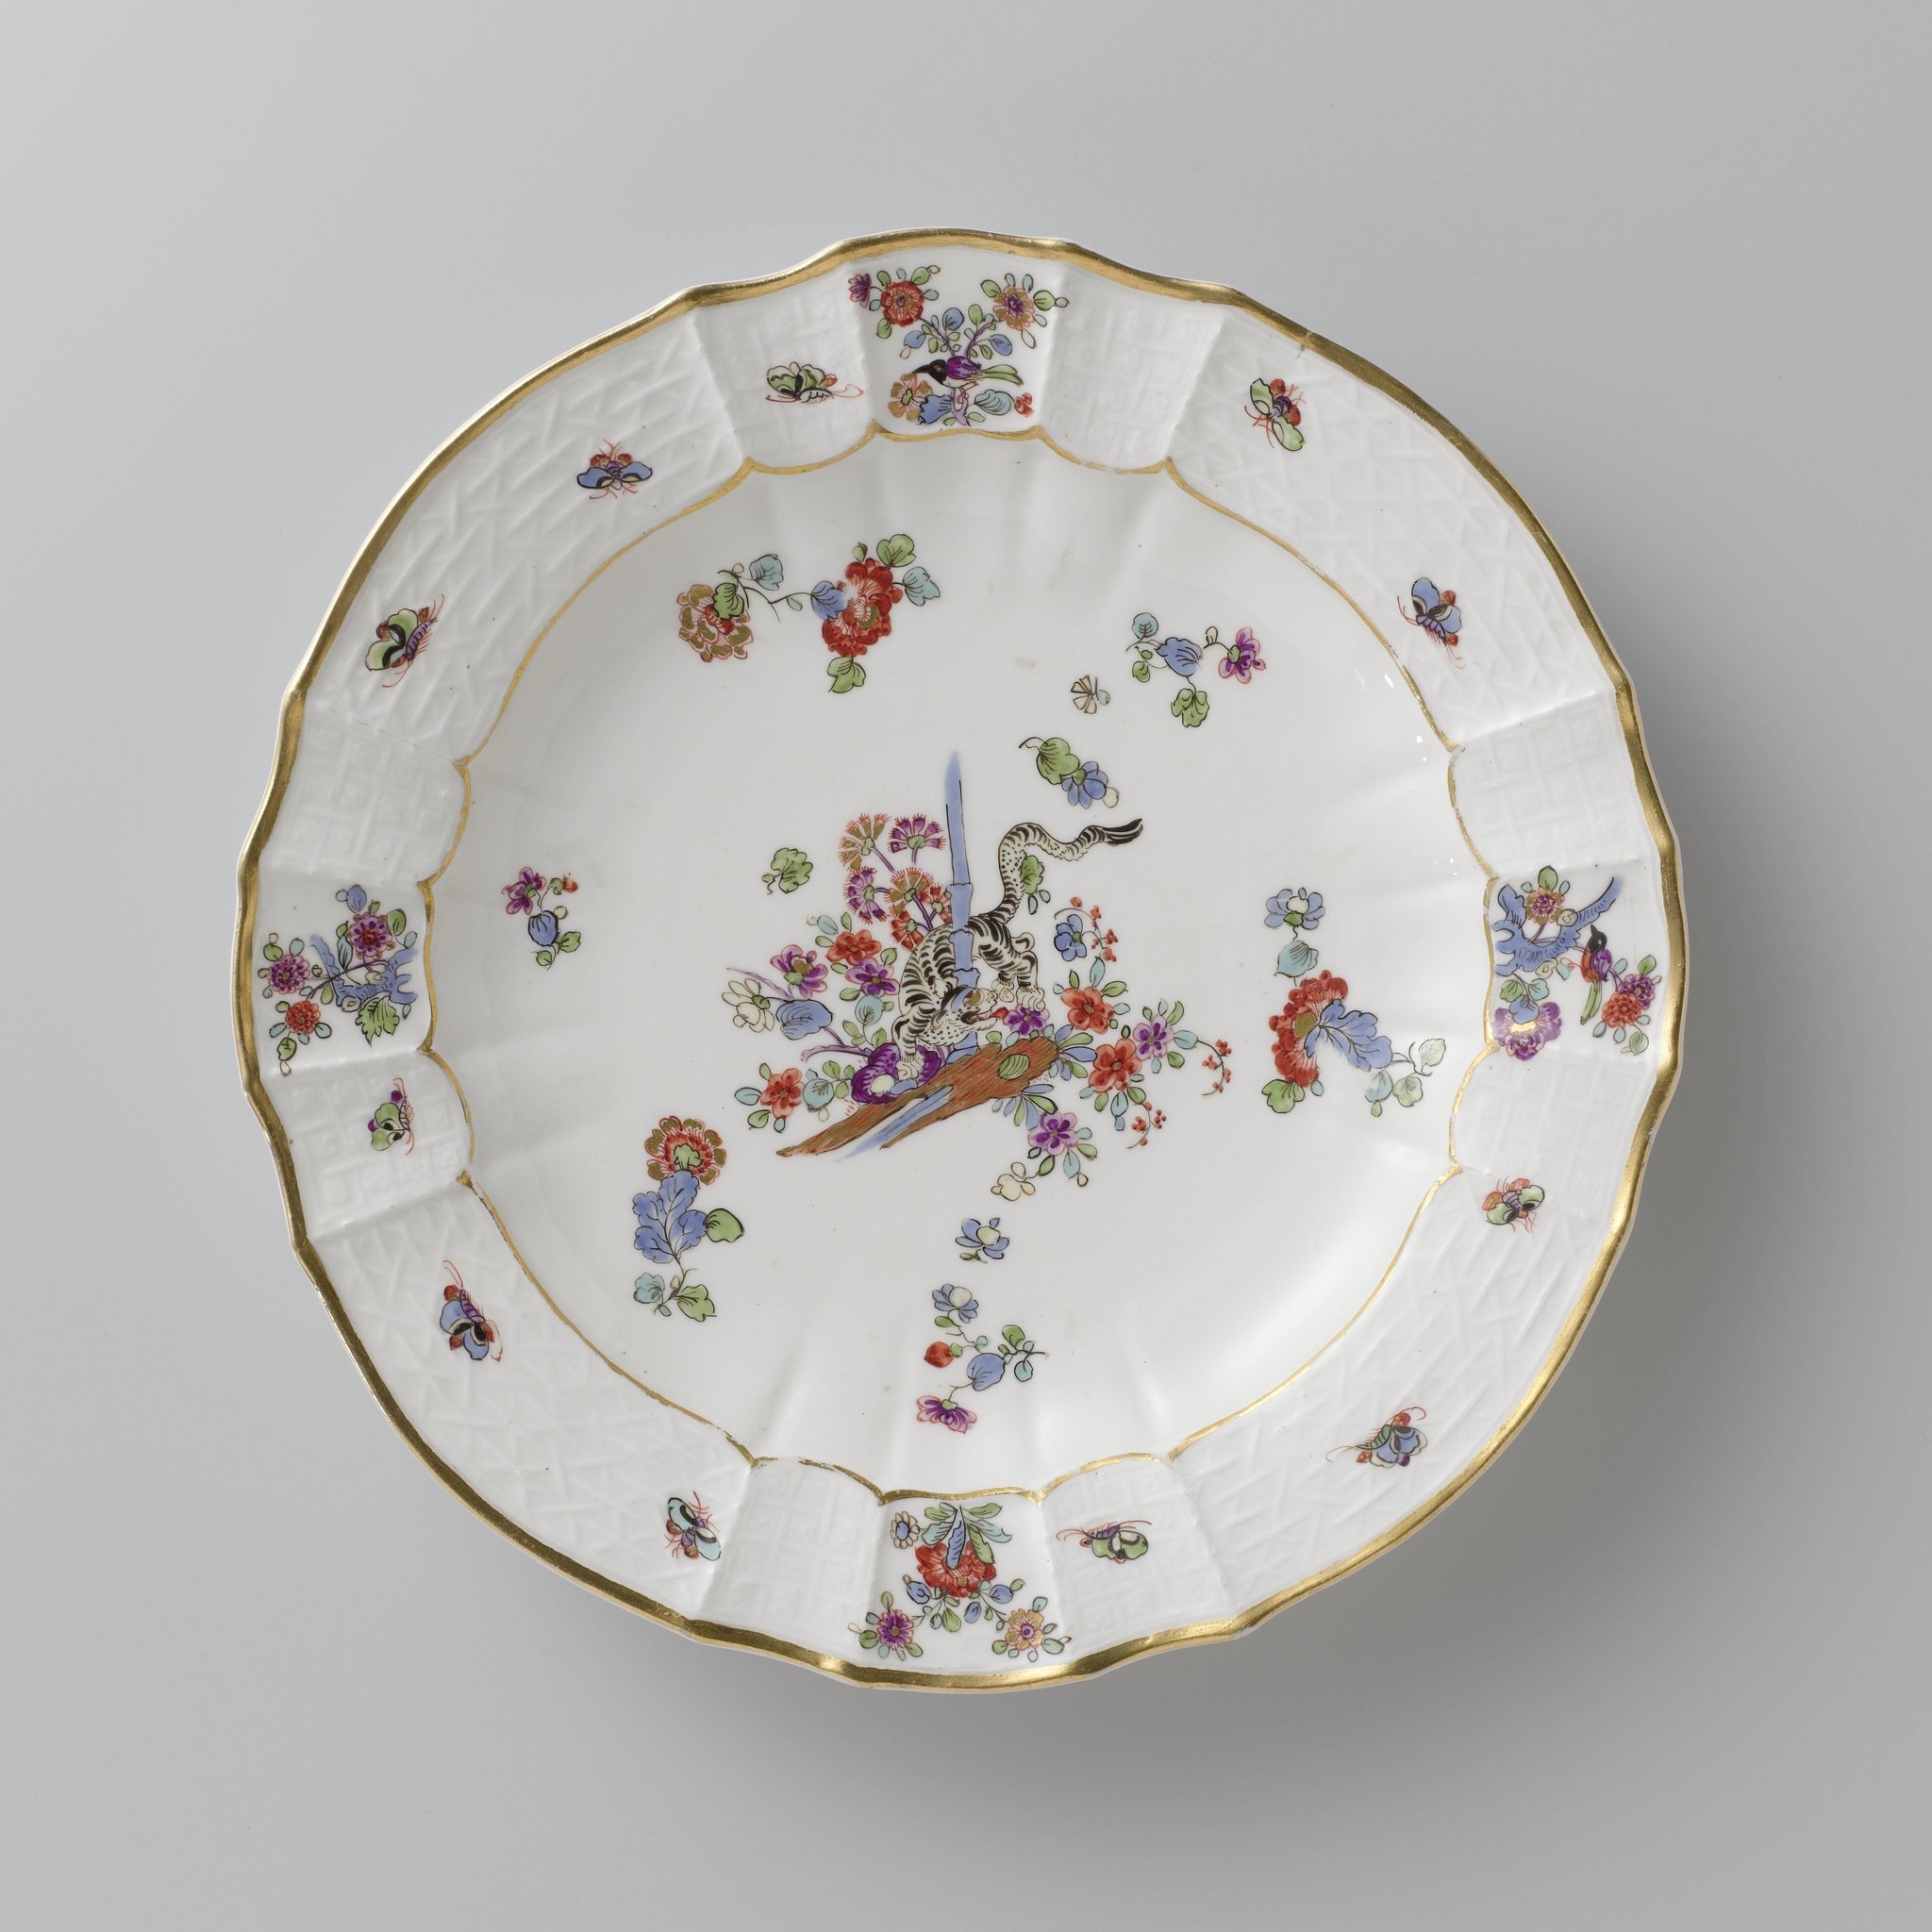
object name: plate dish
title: Rond bord, veelkleurig beschilderd met een Kakiemon-decor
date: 1740-1745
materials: porcelain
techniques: painted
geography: meissen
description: Rond bord van beschilderd porselein. Het bord is geribd en heeft een geschulpte rand. Het bord is beschilderd met een tijger die om een blauwe bamboestengel tussen bloemen is gedraaid, gestrooide Indianische Blumen, vlinders en takken waarop vogels. De rand is versierd met het 'Altbrandenstein'-patroon. Het bord is gemerkt.